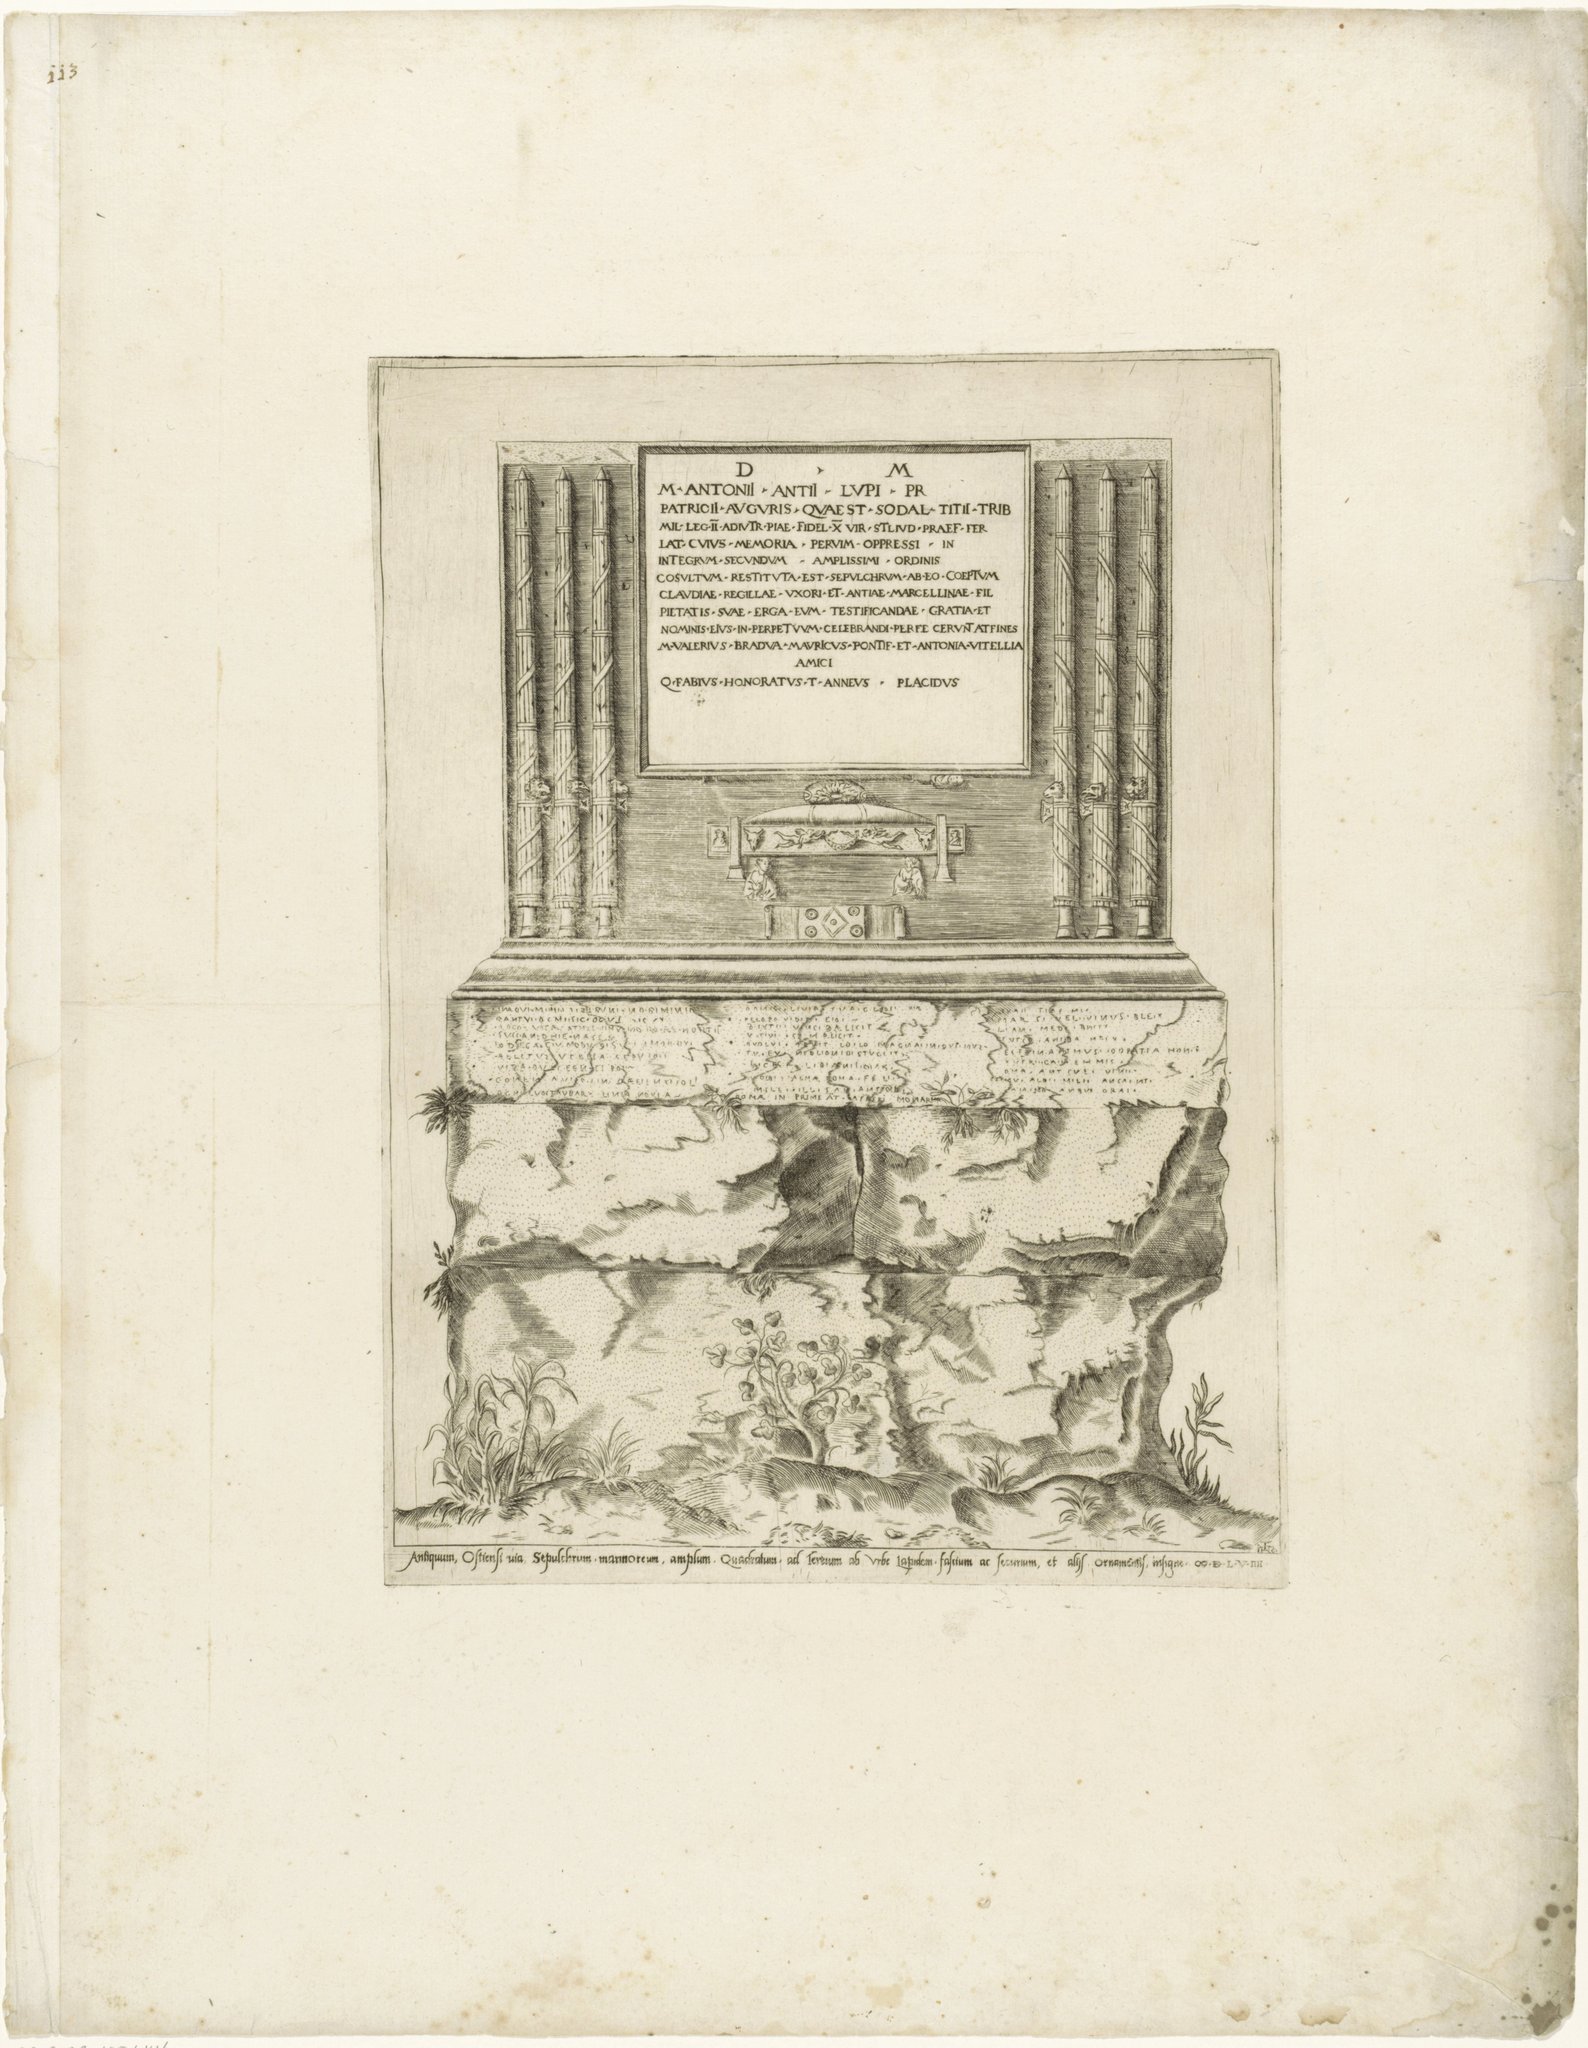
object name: album leaf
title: Grafmonument aan de Via Ostienze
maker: monogrammist ihs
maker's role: print maker, publisher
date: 1559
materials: paper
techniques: engraving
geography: italy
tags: grave, tomb, rome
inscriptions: watermark, number: ‘113’, collector's mark: Lugt 2228, collector's mark: Lugt 2760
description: Folio 113 uit het prentalbum van Johann Georg I. Zobel von Giebelstadt (Röttingen 1543-07-20 - Bamberg 1580-09-07), de latere bisschop van Bamberg. Het album is vermoedelijk samengesteld tussen 1568 en 1570 in Venetië. Het album werd in 1999 uit elkaar genomen door een antiquair. De in totaal 124 folio's met prenten uit het "Zobel Album" werden aangekocht door verschillende musea en privéverzamelingen. De grootste groep (68 folio's) bevindt zich in de collectie van het Rijksmuseum. Spiegelbeeldige kopie naar een prent door een anonieme prentmaker, uitgegeven door Antonio Lafereri (Londen, British Museum, inv. nr.: 1947,0319.26.108).